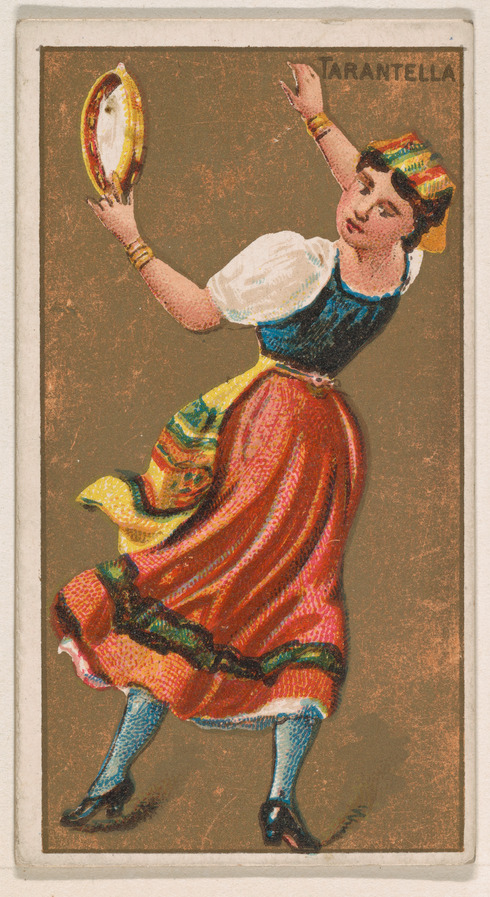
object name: print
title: Tarantella, from National Dances (N225, Type 1) issued by Kinney Bros.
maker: kinney brothers tobacco company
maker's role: publisher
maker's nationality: american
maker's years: 1869-2011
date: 1889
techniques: color lithograph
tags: women,dancing,dancers